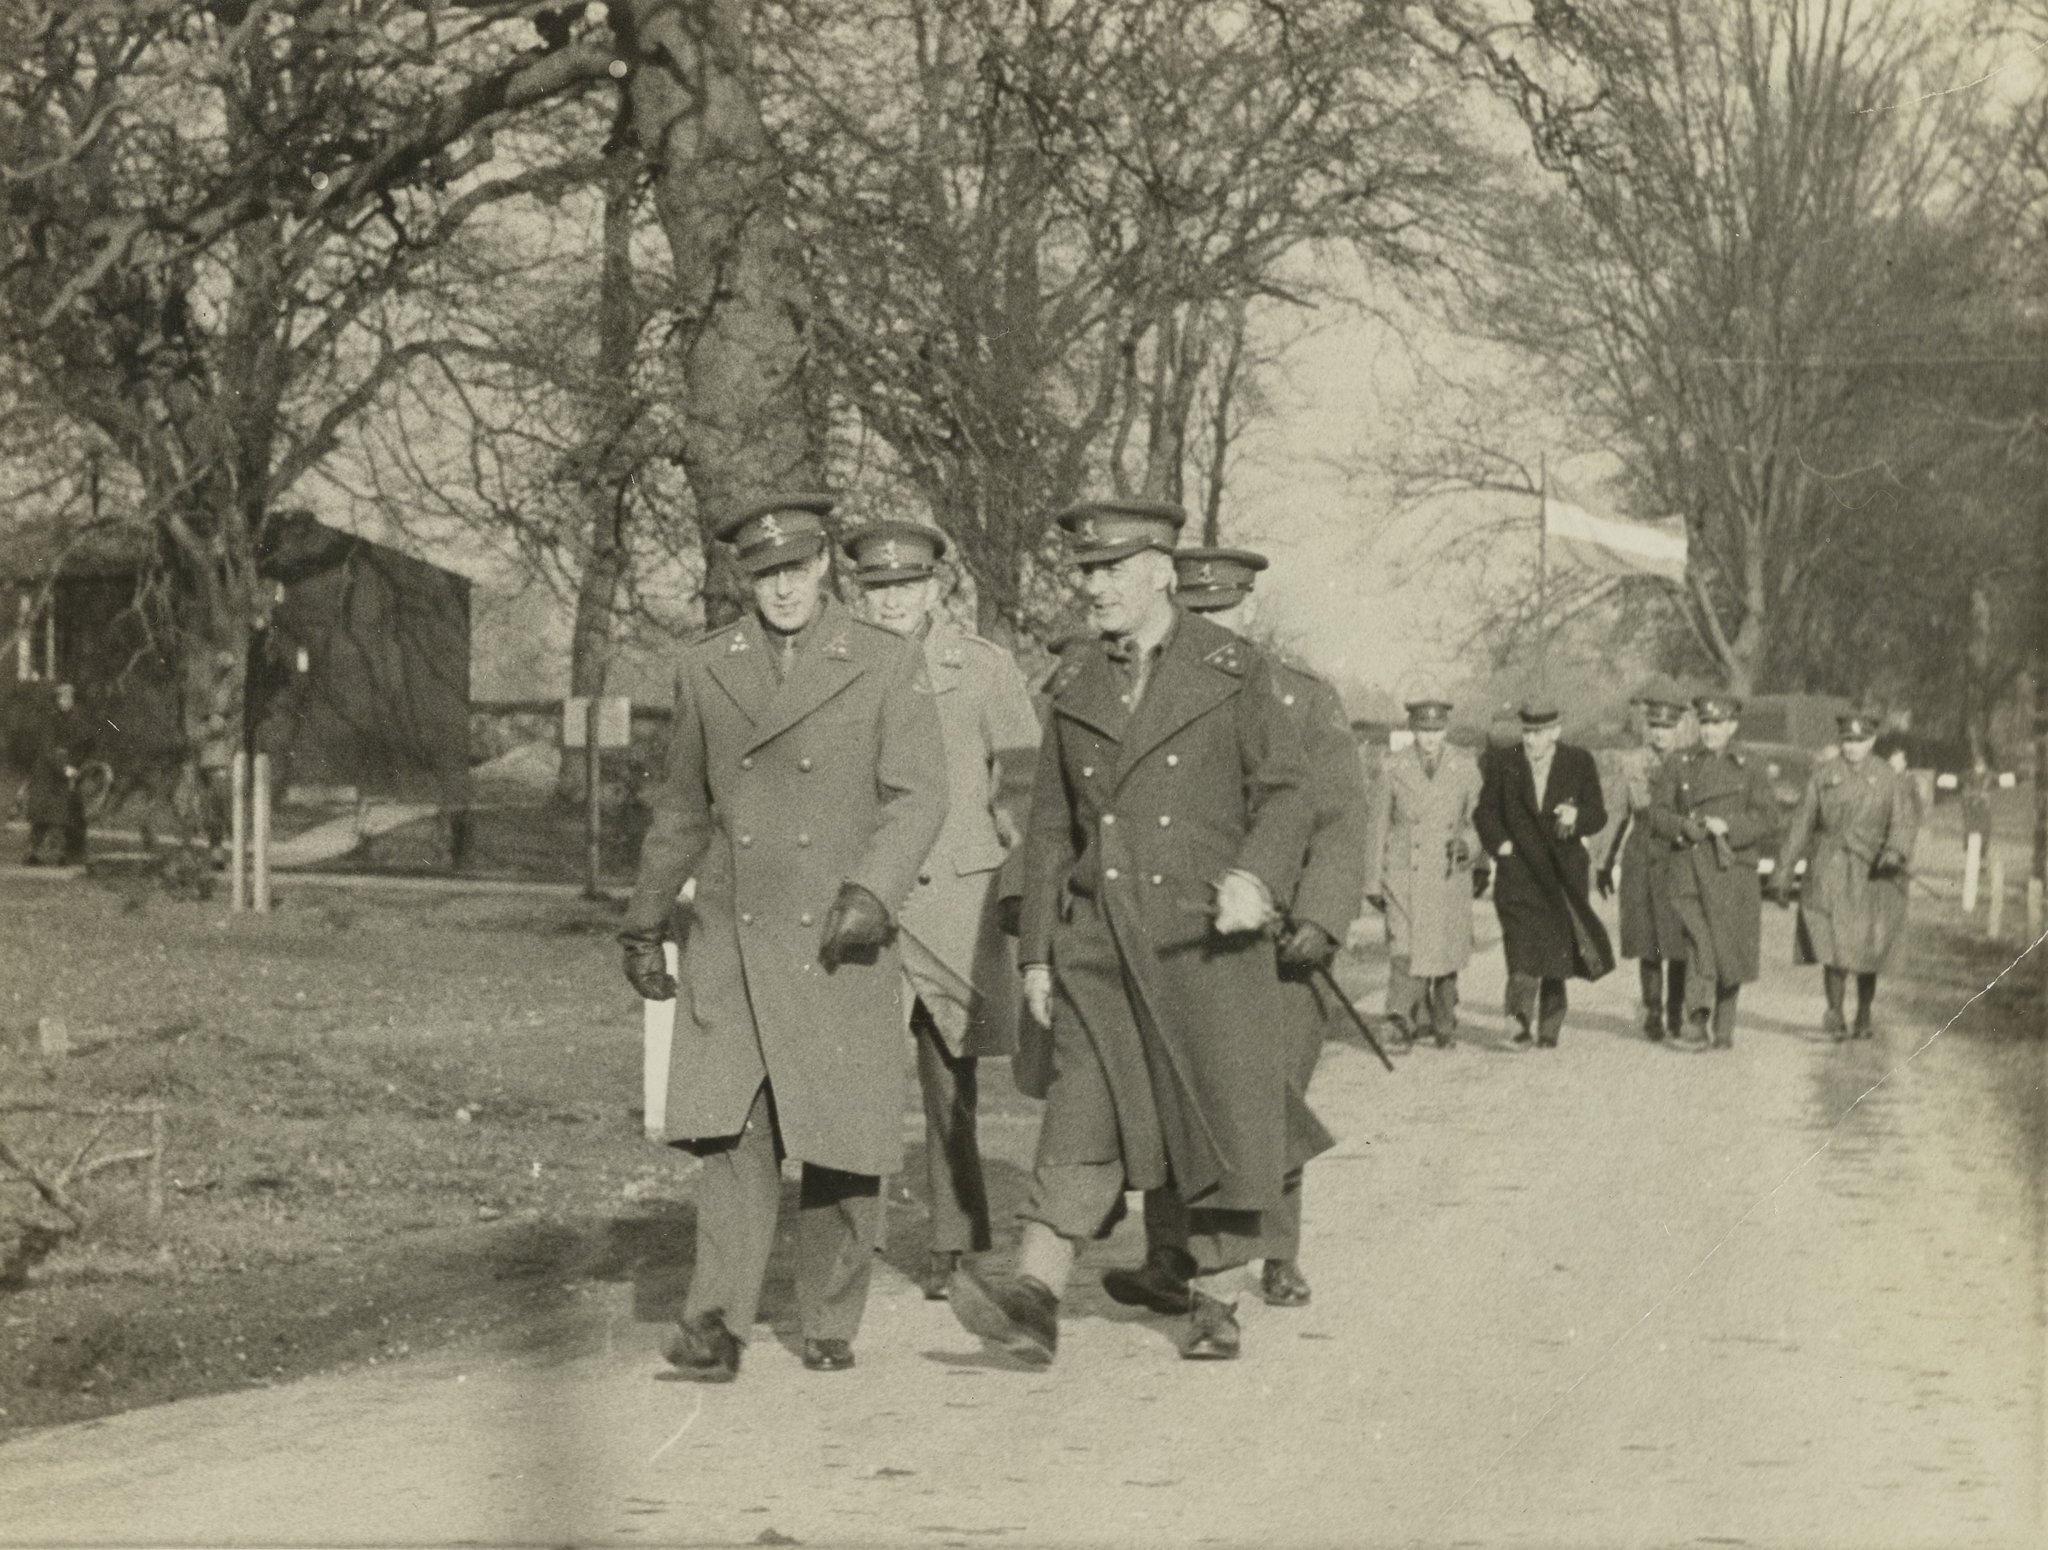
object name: photograph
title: Prins Bernhard en Nederlandse militairen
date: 1940-1945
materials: photographic support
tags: utrecht, bernhard (prins der nederlanden), print maker, cor visser, london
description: Foto gebruikt door Cor Visser tijdens zijn verblijf in Londen in de Tweede Wereldoorlog waar hij tekende voor de Nederlandse regering.